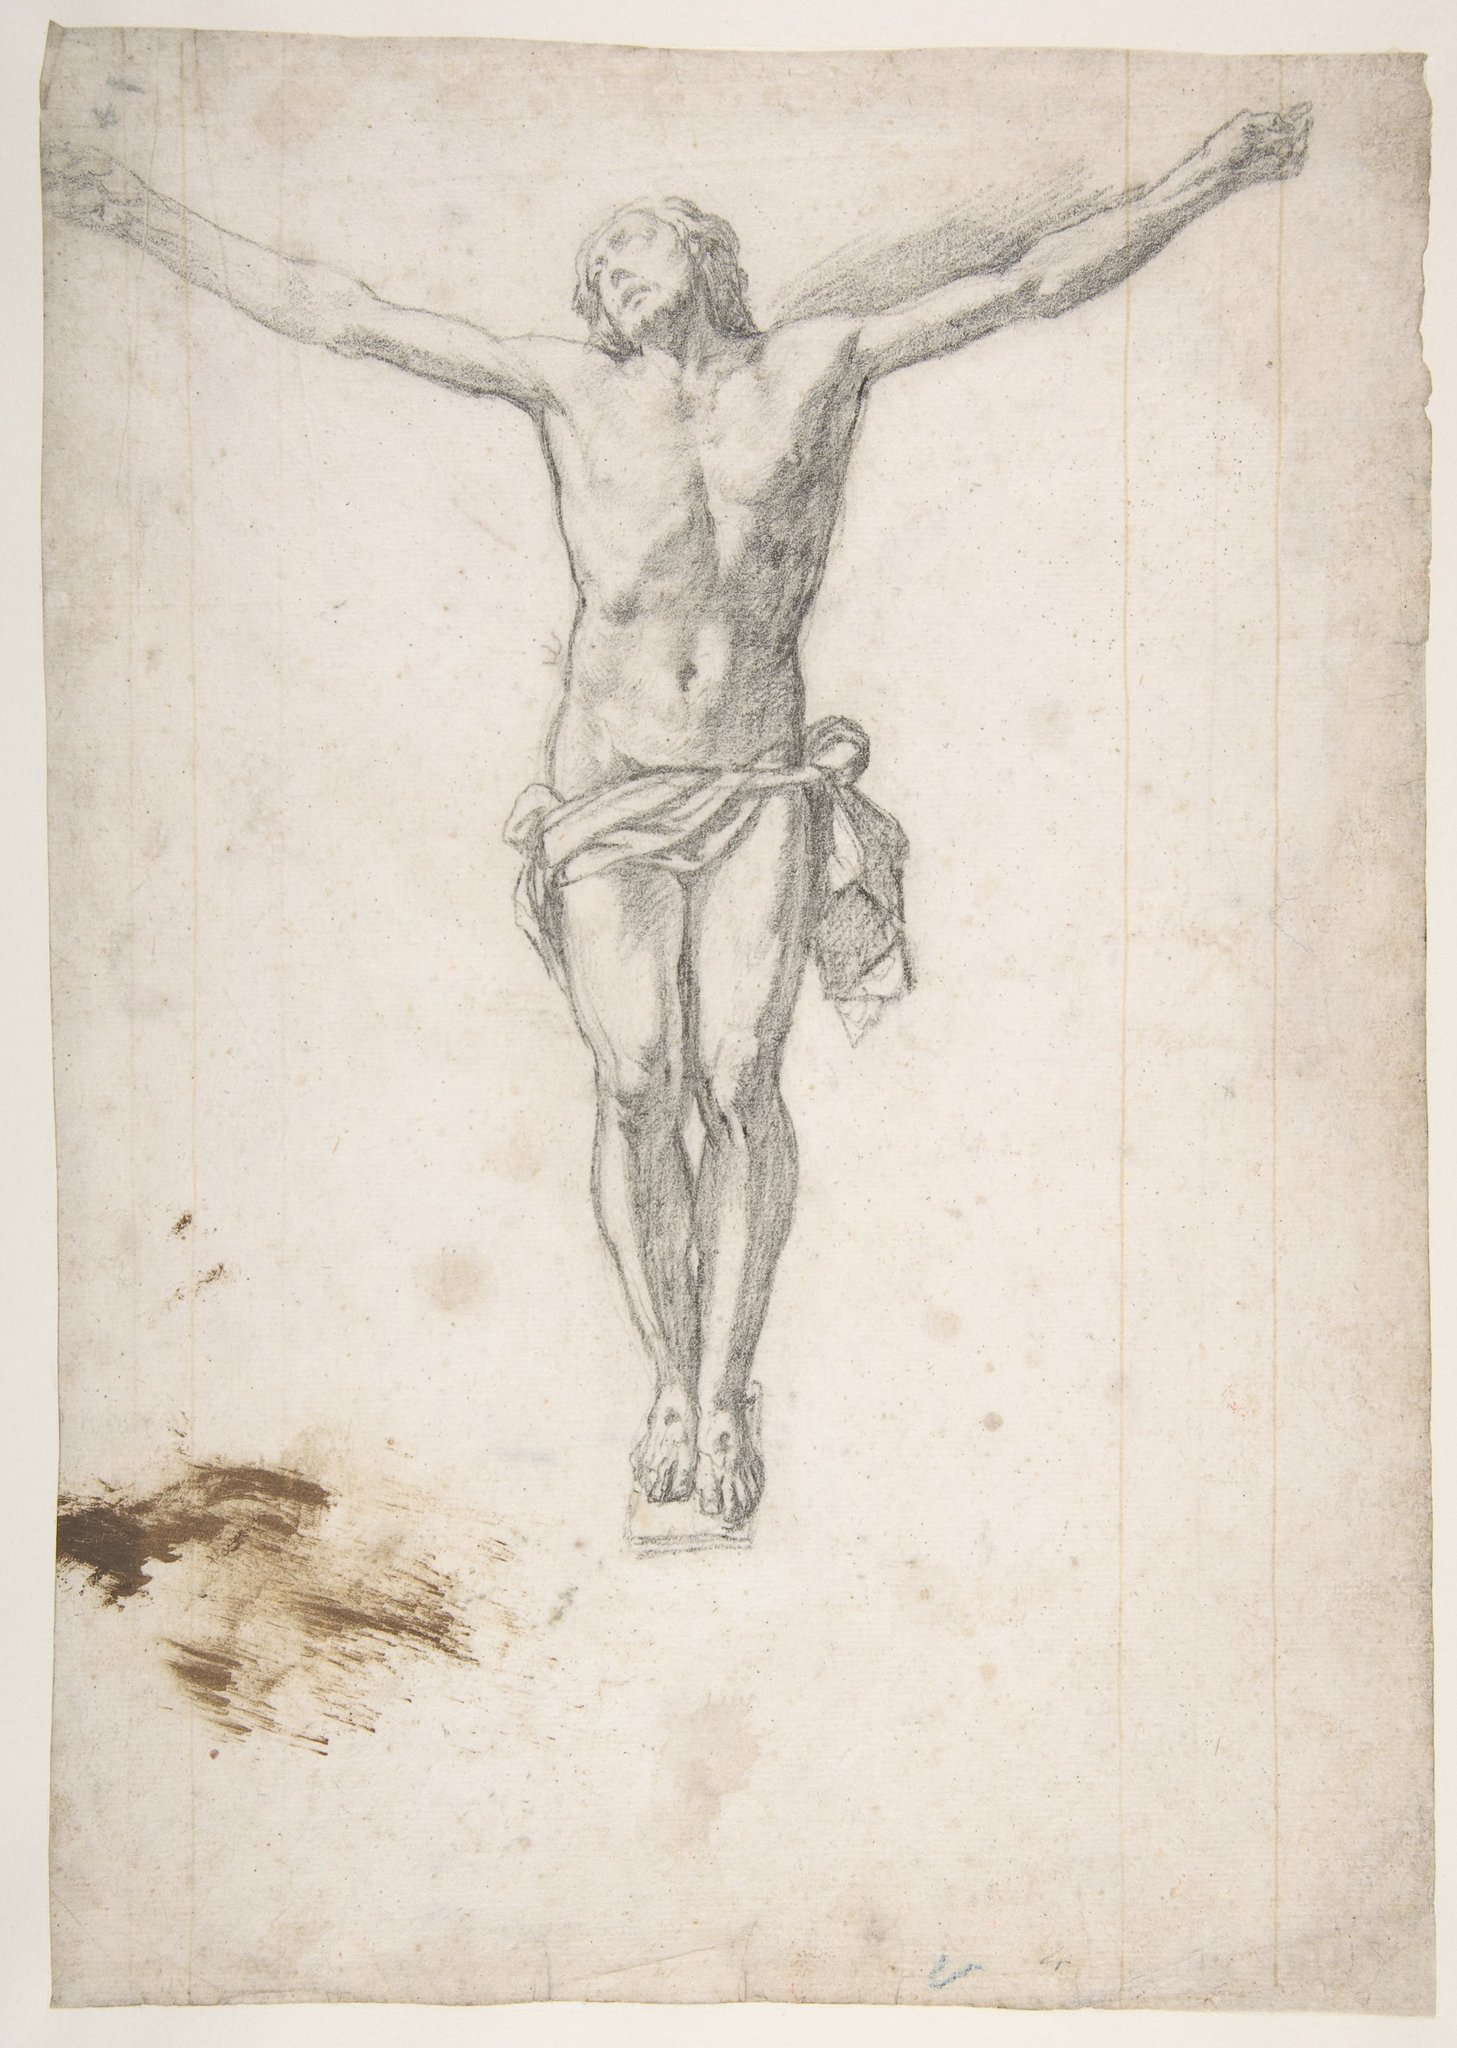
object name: drawing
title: Christ on the Cross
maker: girolamo muziano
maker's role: artist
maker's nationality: italian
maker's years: 1528-1592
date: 1590-1600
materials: chalk, oil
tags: christ,crucifixion